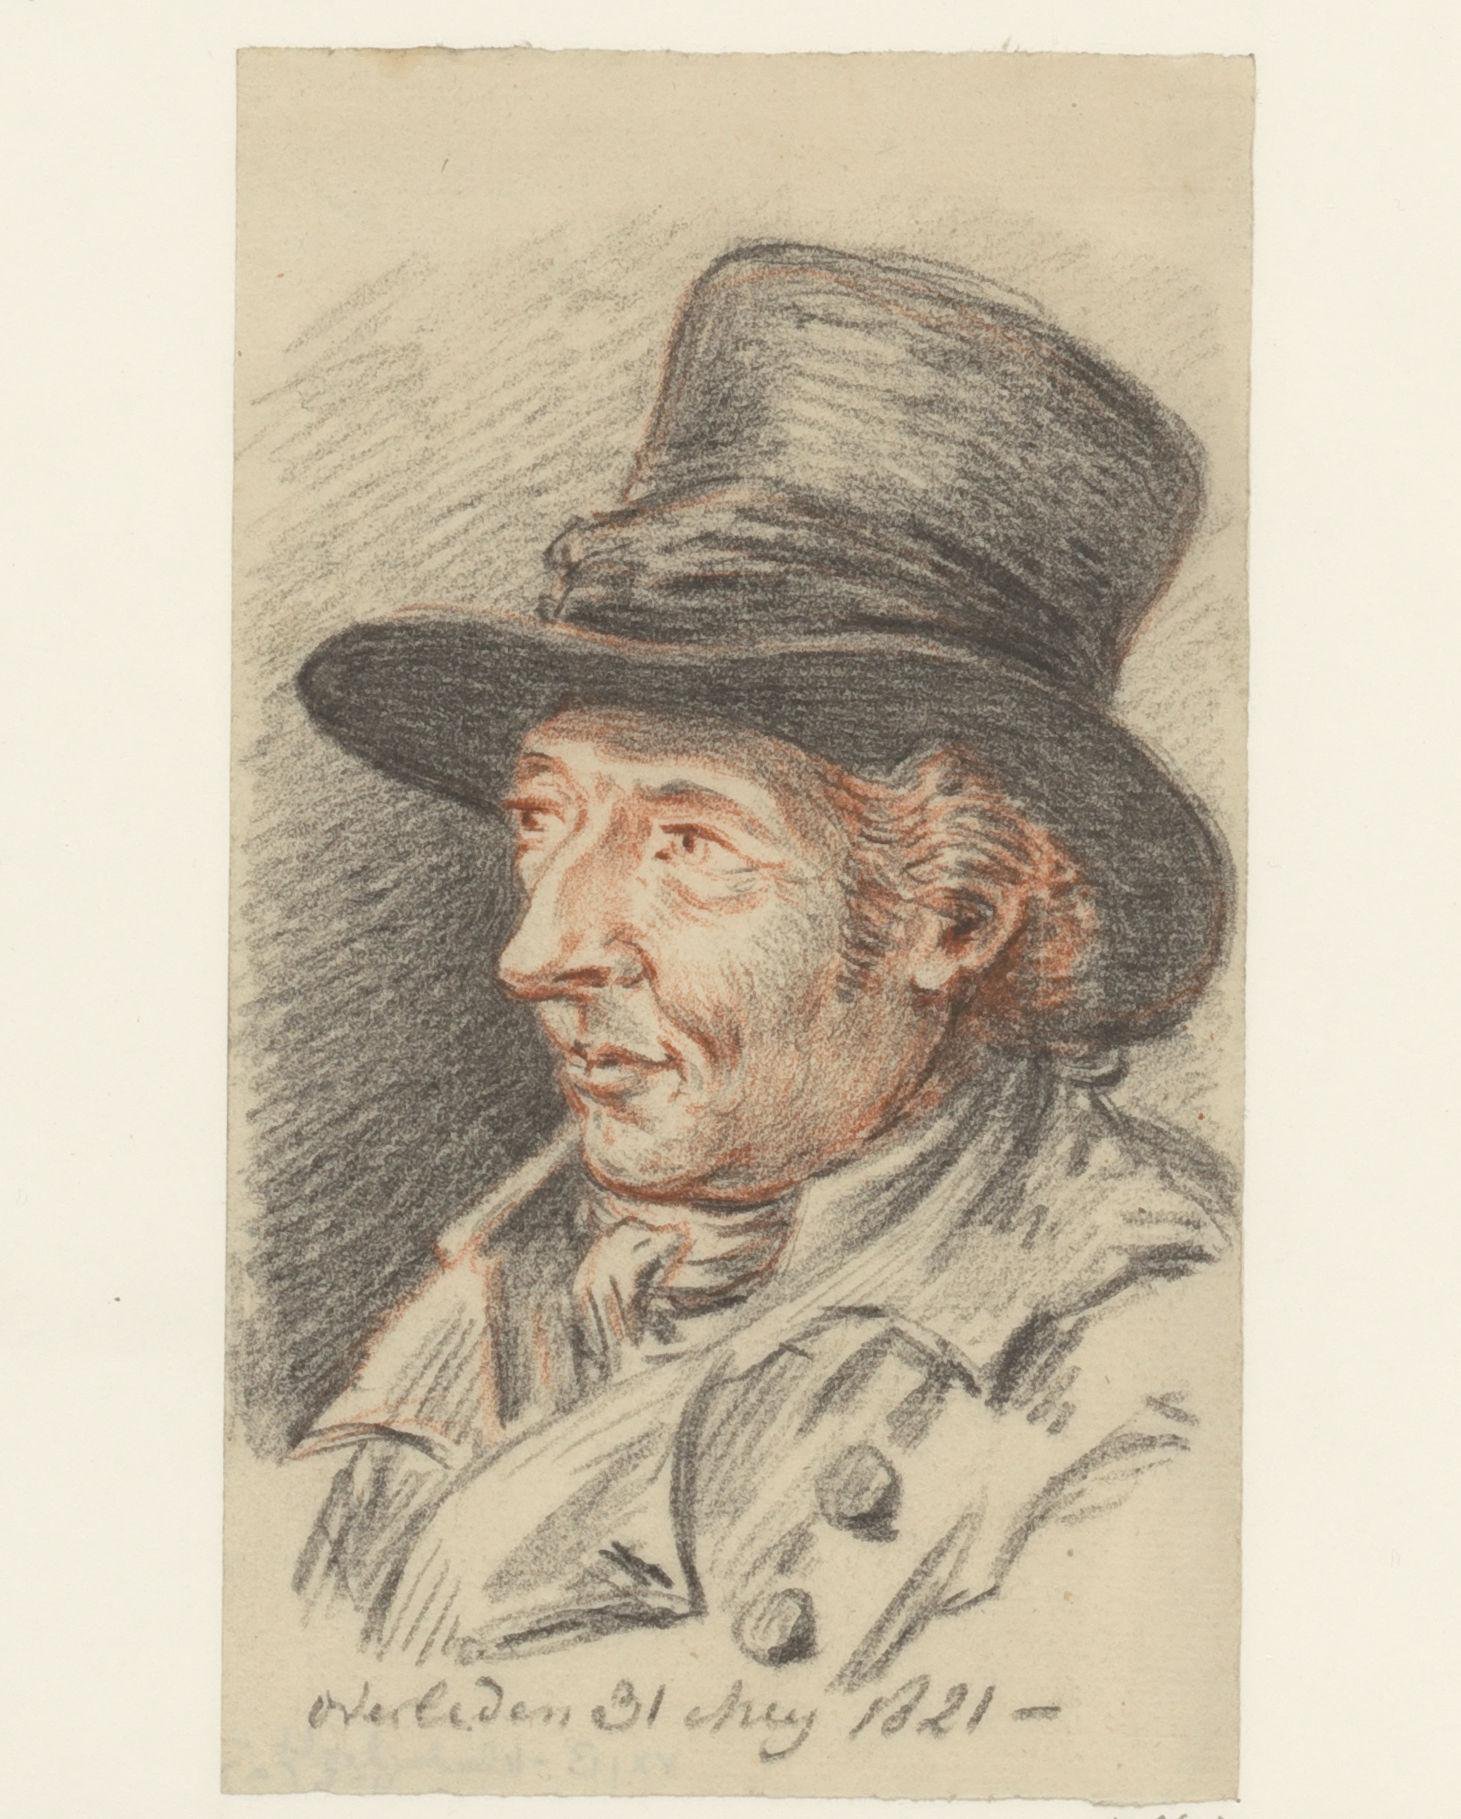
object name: drawing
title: Man met hoge hoed, overleden op 31 mei 1821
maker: jean bernard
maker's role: draughtsman, print maker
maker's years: 1765-1833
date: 1821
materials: chalk, paper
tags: pipe ~ tobacco, clothes, costume, head-gear: top hat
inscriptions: stamp, collector's mark: Lugt 1641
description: Onderwerpsrubrieken binnen de Atlas Zeden en Gewoonten: Zeden en Gewoonten in Engeren Zin, De Kleeding, Kleederdrachten (tijdvakken), De regeering van Willem I. Mannen en vrouwen.